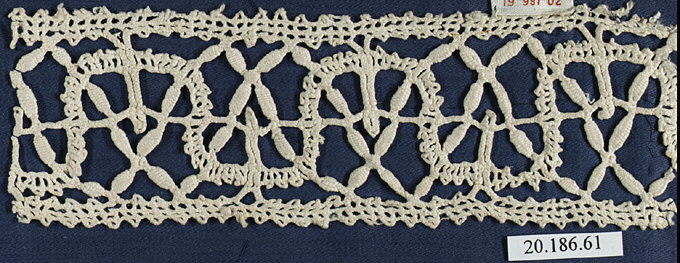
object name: insertion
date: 1601-1700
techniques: lace